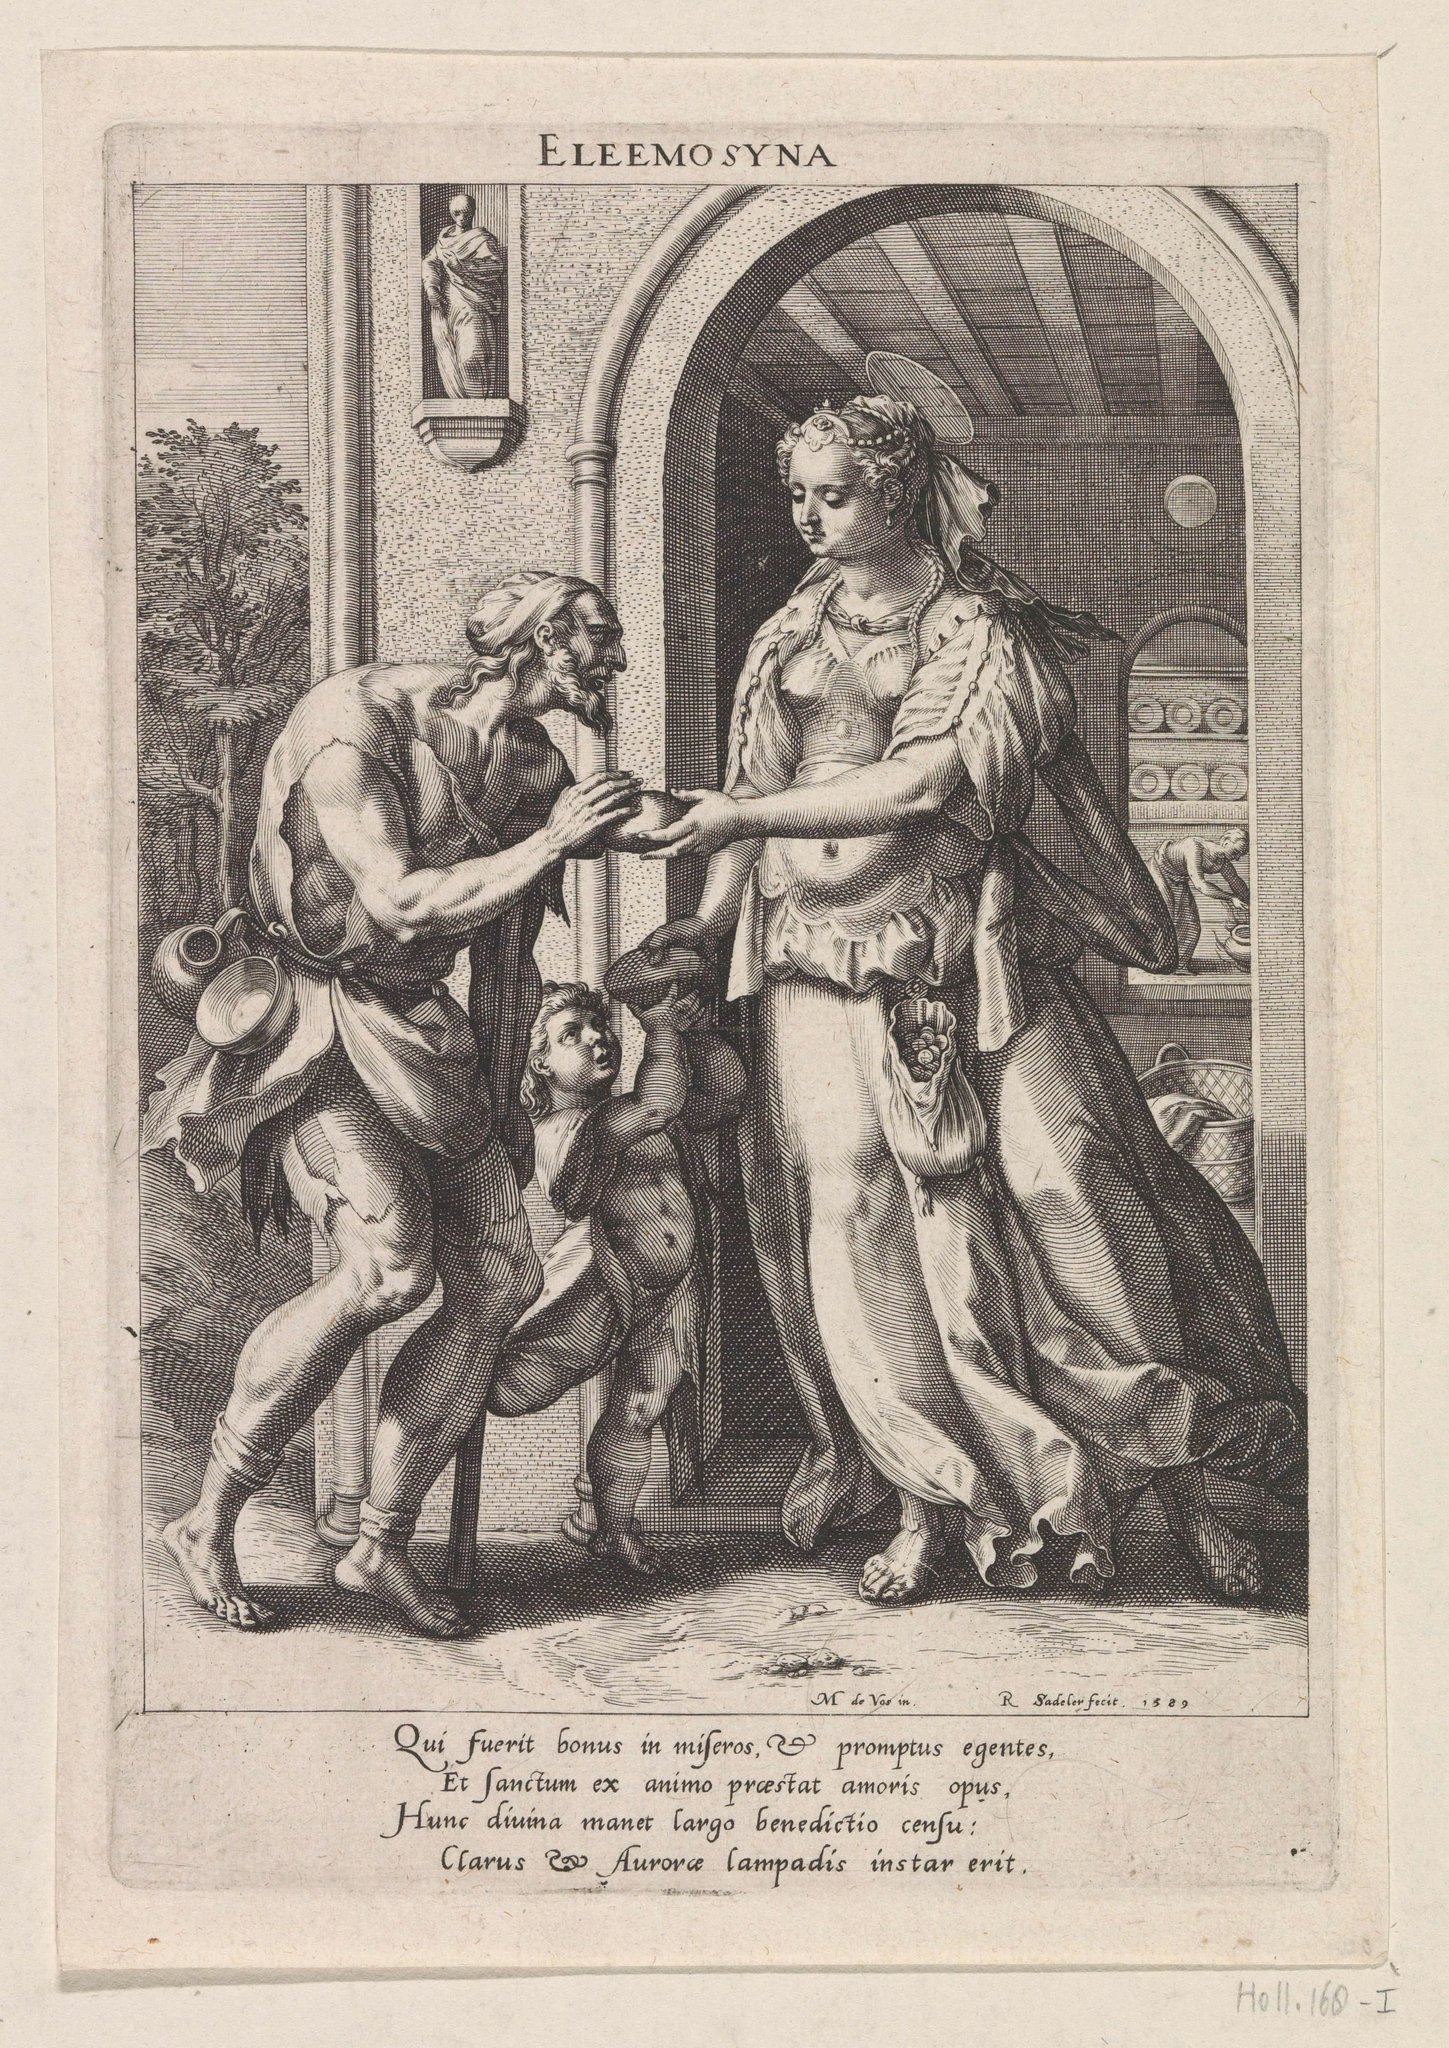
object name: print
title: Liefdadigheid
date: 1589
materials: paper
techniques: engraving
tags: giving alms or other charity, e.g.: handing out food, crutches, disabilities, deformations, beggar, generosity, liberality; 'generosità', 'liberalità' (ripa), 'elemosina' (ripa)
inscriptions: collector's mark: Lugt 240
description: De vrouwelijke personificatie van Liefdadigheid (Elemosina). Ze staat voor een deuropening en geeft twee broden aan twee bedelaars: een kind en een man steunend op een okselkruk. De vierde prent uit een serie met als onderwerp zes christelijke deugden.